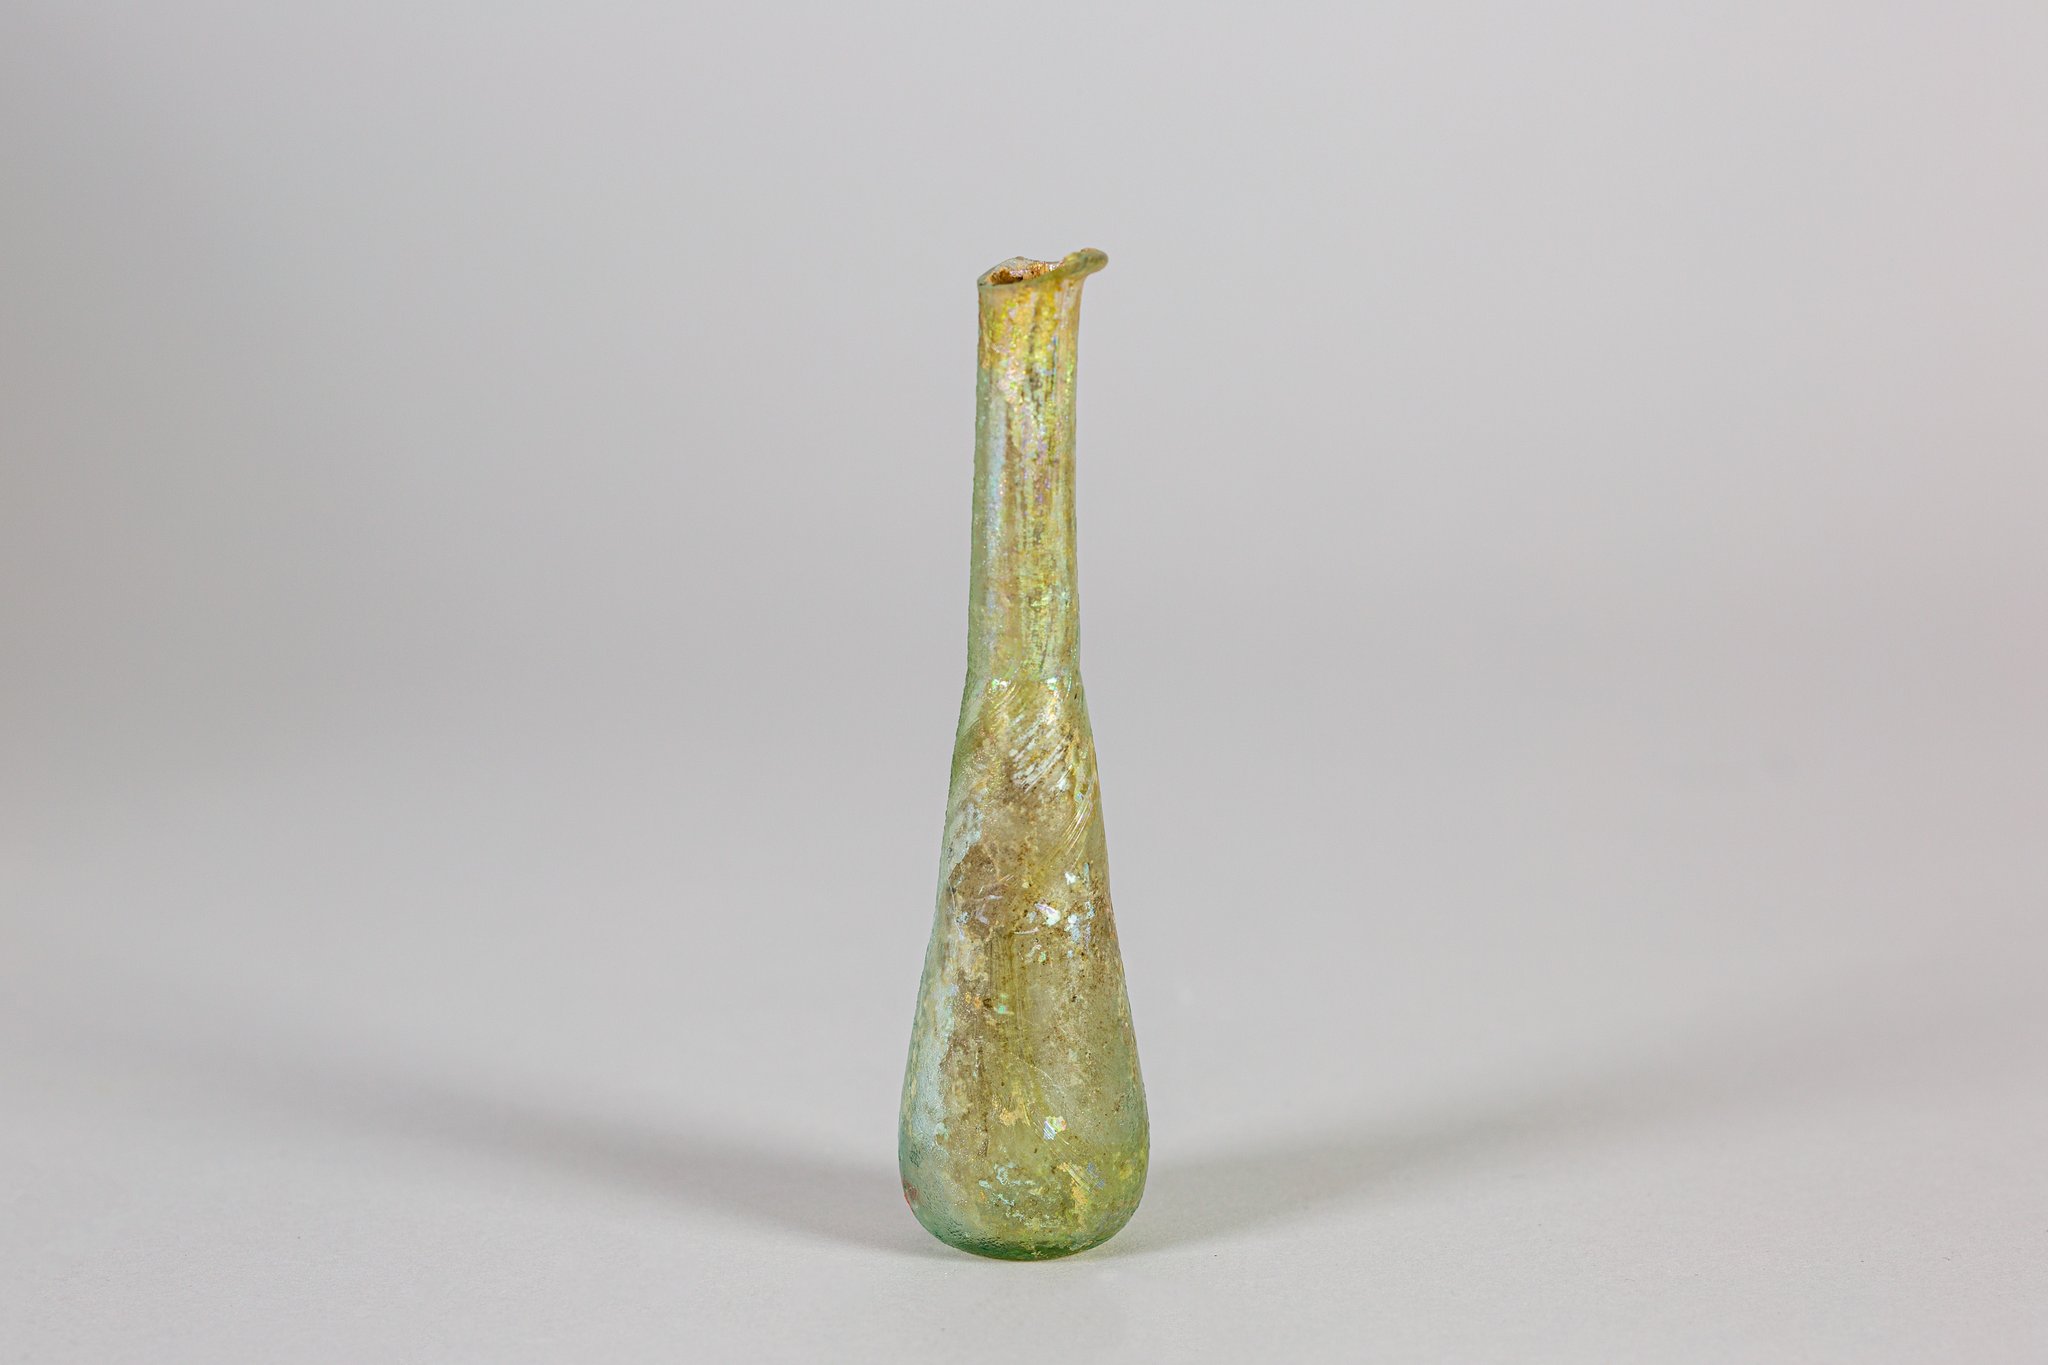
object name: perfume bottle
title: Glass perfume bottle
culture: roman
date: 67-300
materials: glass